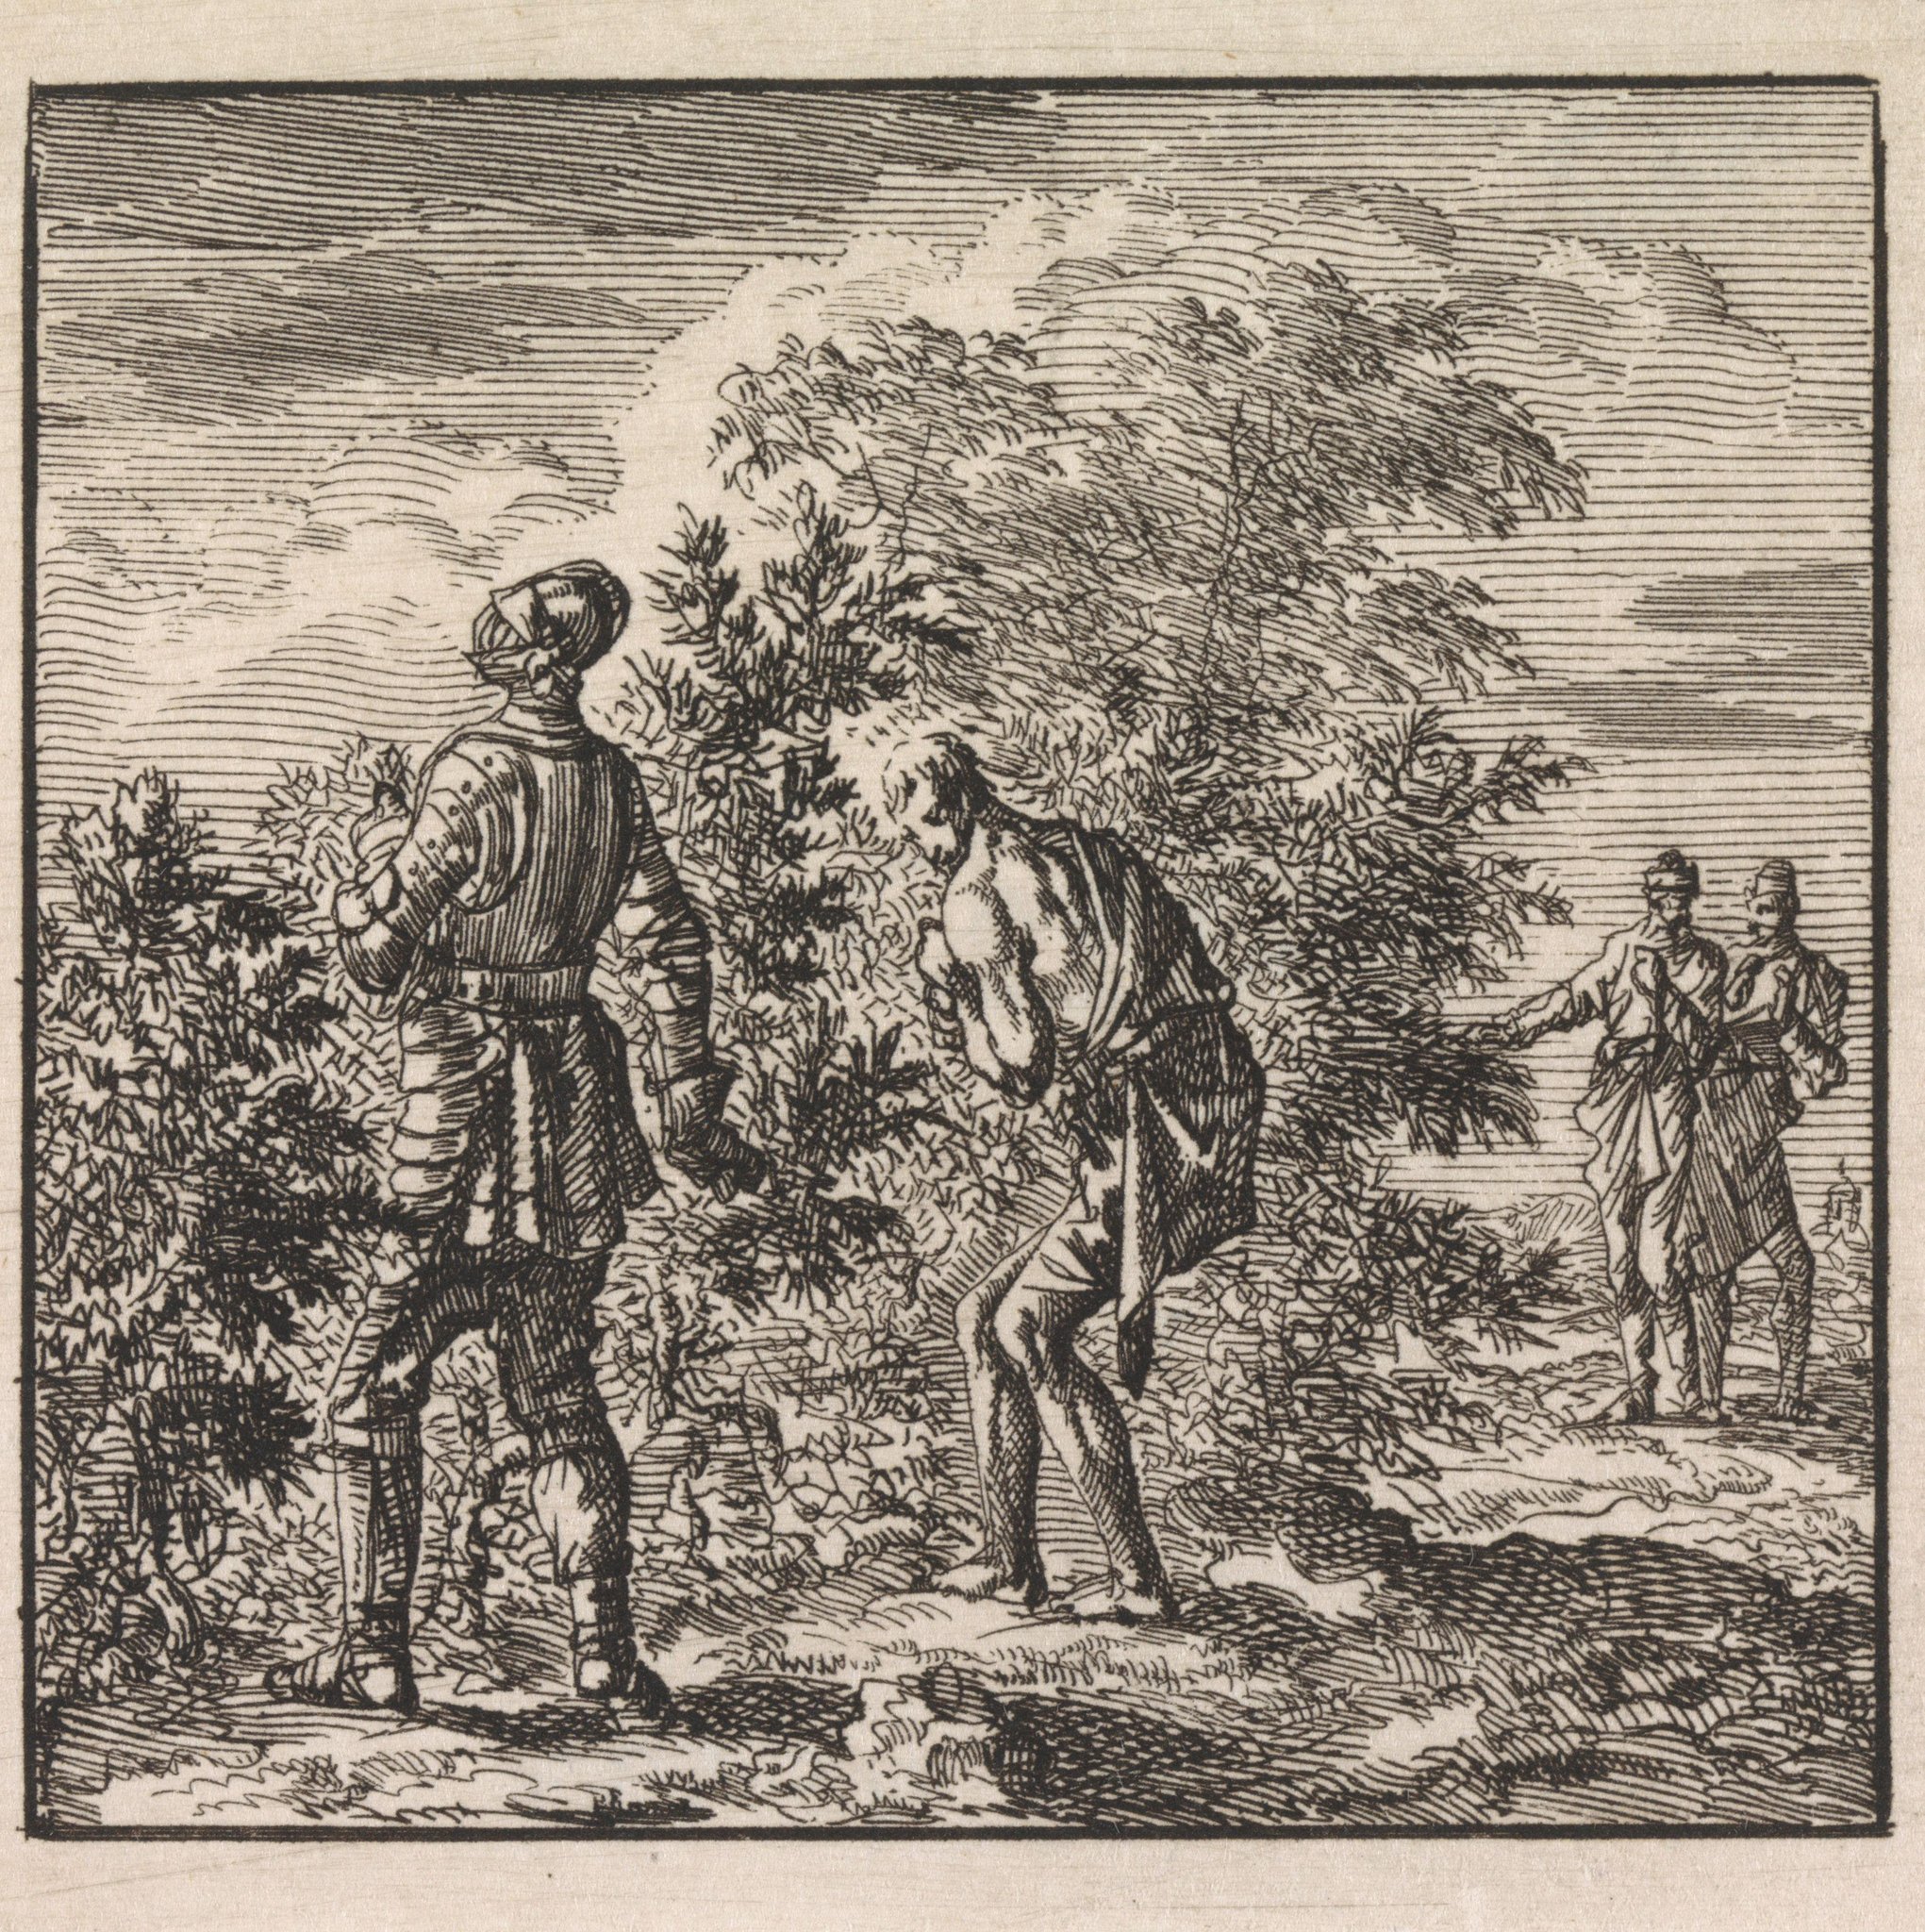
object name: print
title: Geharnaste man en een halfnaakte man proberen door een stekelbos te lopen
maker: jan luyken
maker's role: draughtsman, print maker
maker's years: 1649-1712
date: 1710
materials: paper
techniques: etching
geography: amsterdam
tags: armour, forest, wood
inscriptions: collector's mark: Lugt 2228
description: Proefdruk voor illustratie uit: Luyken, Jan. De onwaardige wereld, vertoond in vyftig zinnebeelden, met godlyke spreuken en stichtelyke verzen. Amsterdam: Pieter Arentsz. II (wed.) en Cornelis van der Sys, 1710, p. 188.